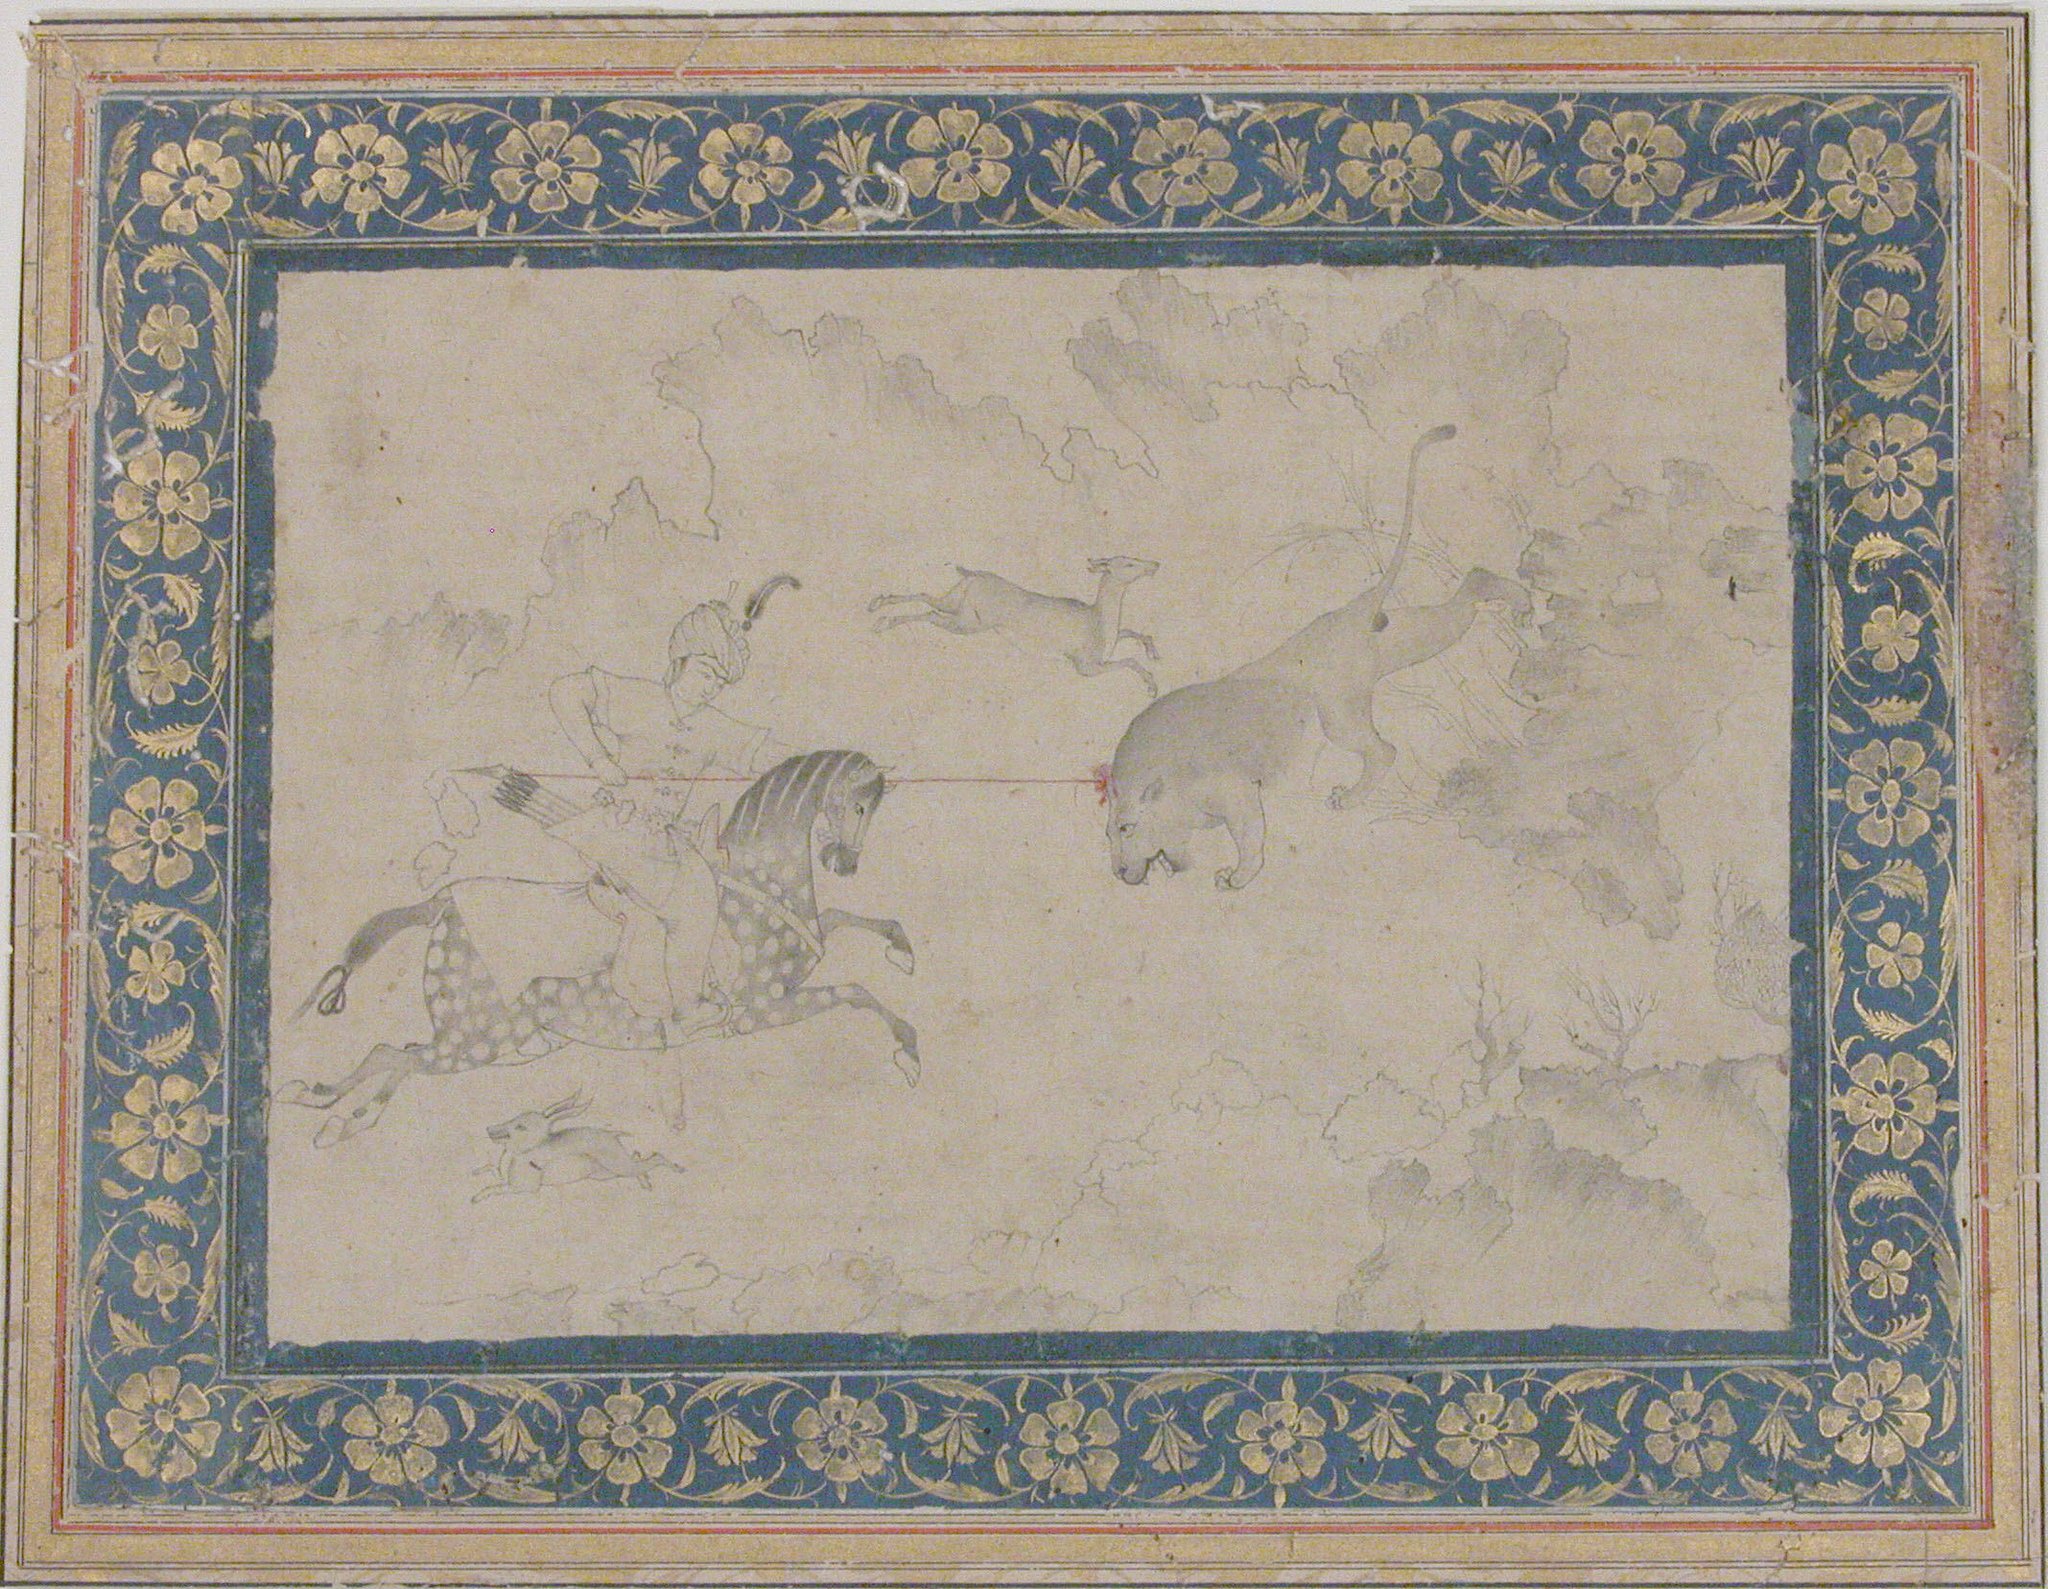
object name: illustrated single work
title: Hunting Scene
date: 1551-1600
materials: ink, paper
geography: iran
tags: weapons,men,hunting,deer,horses